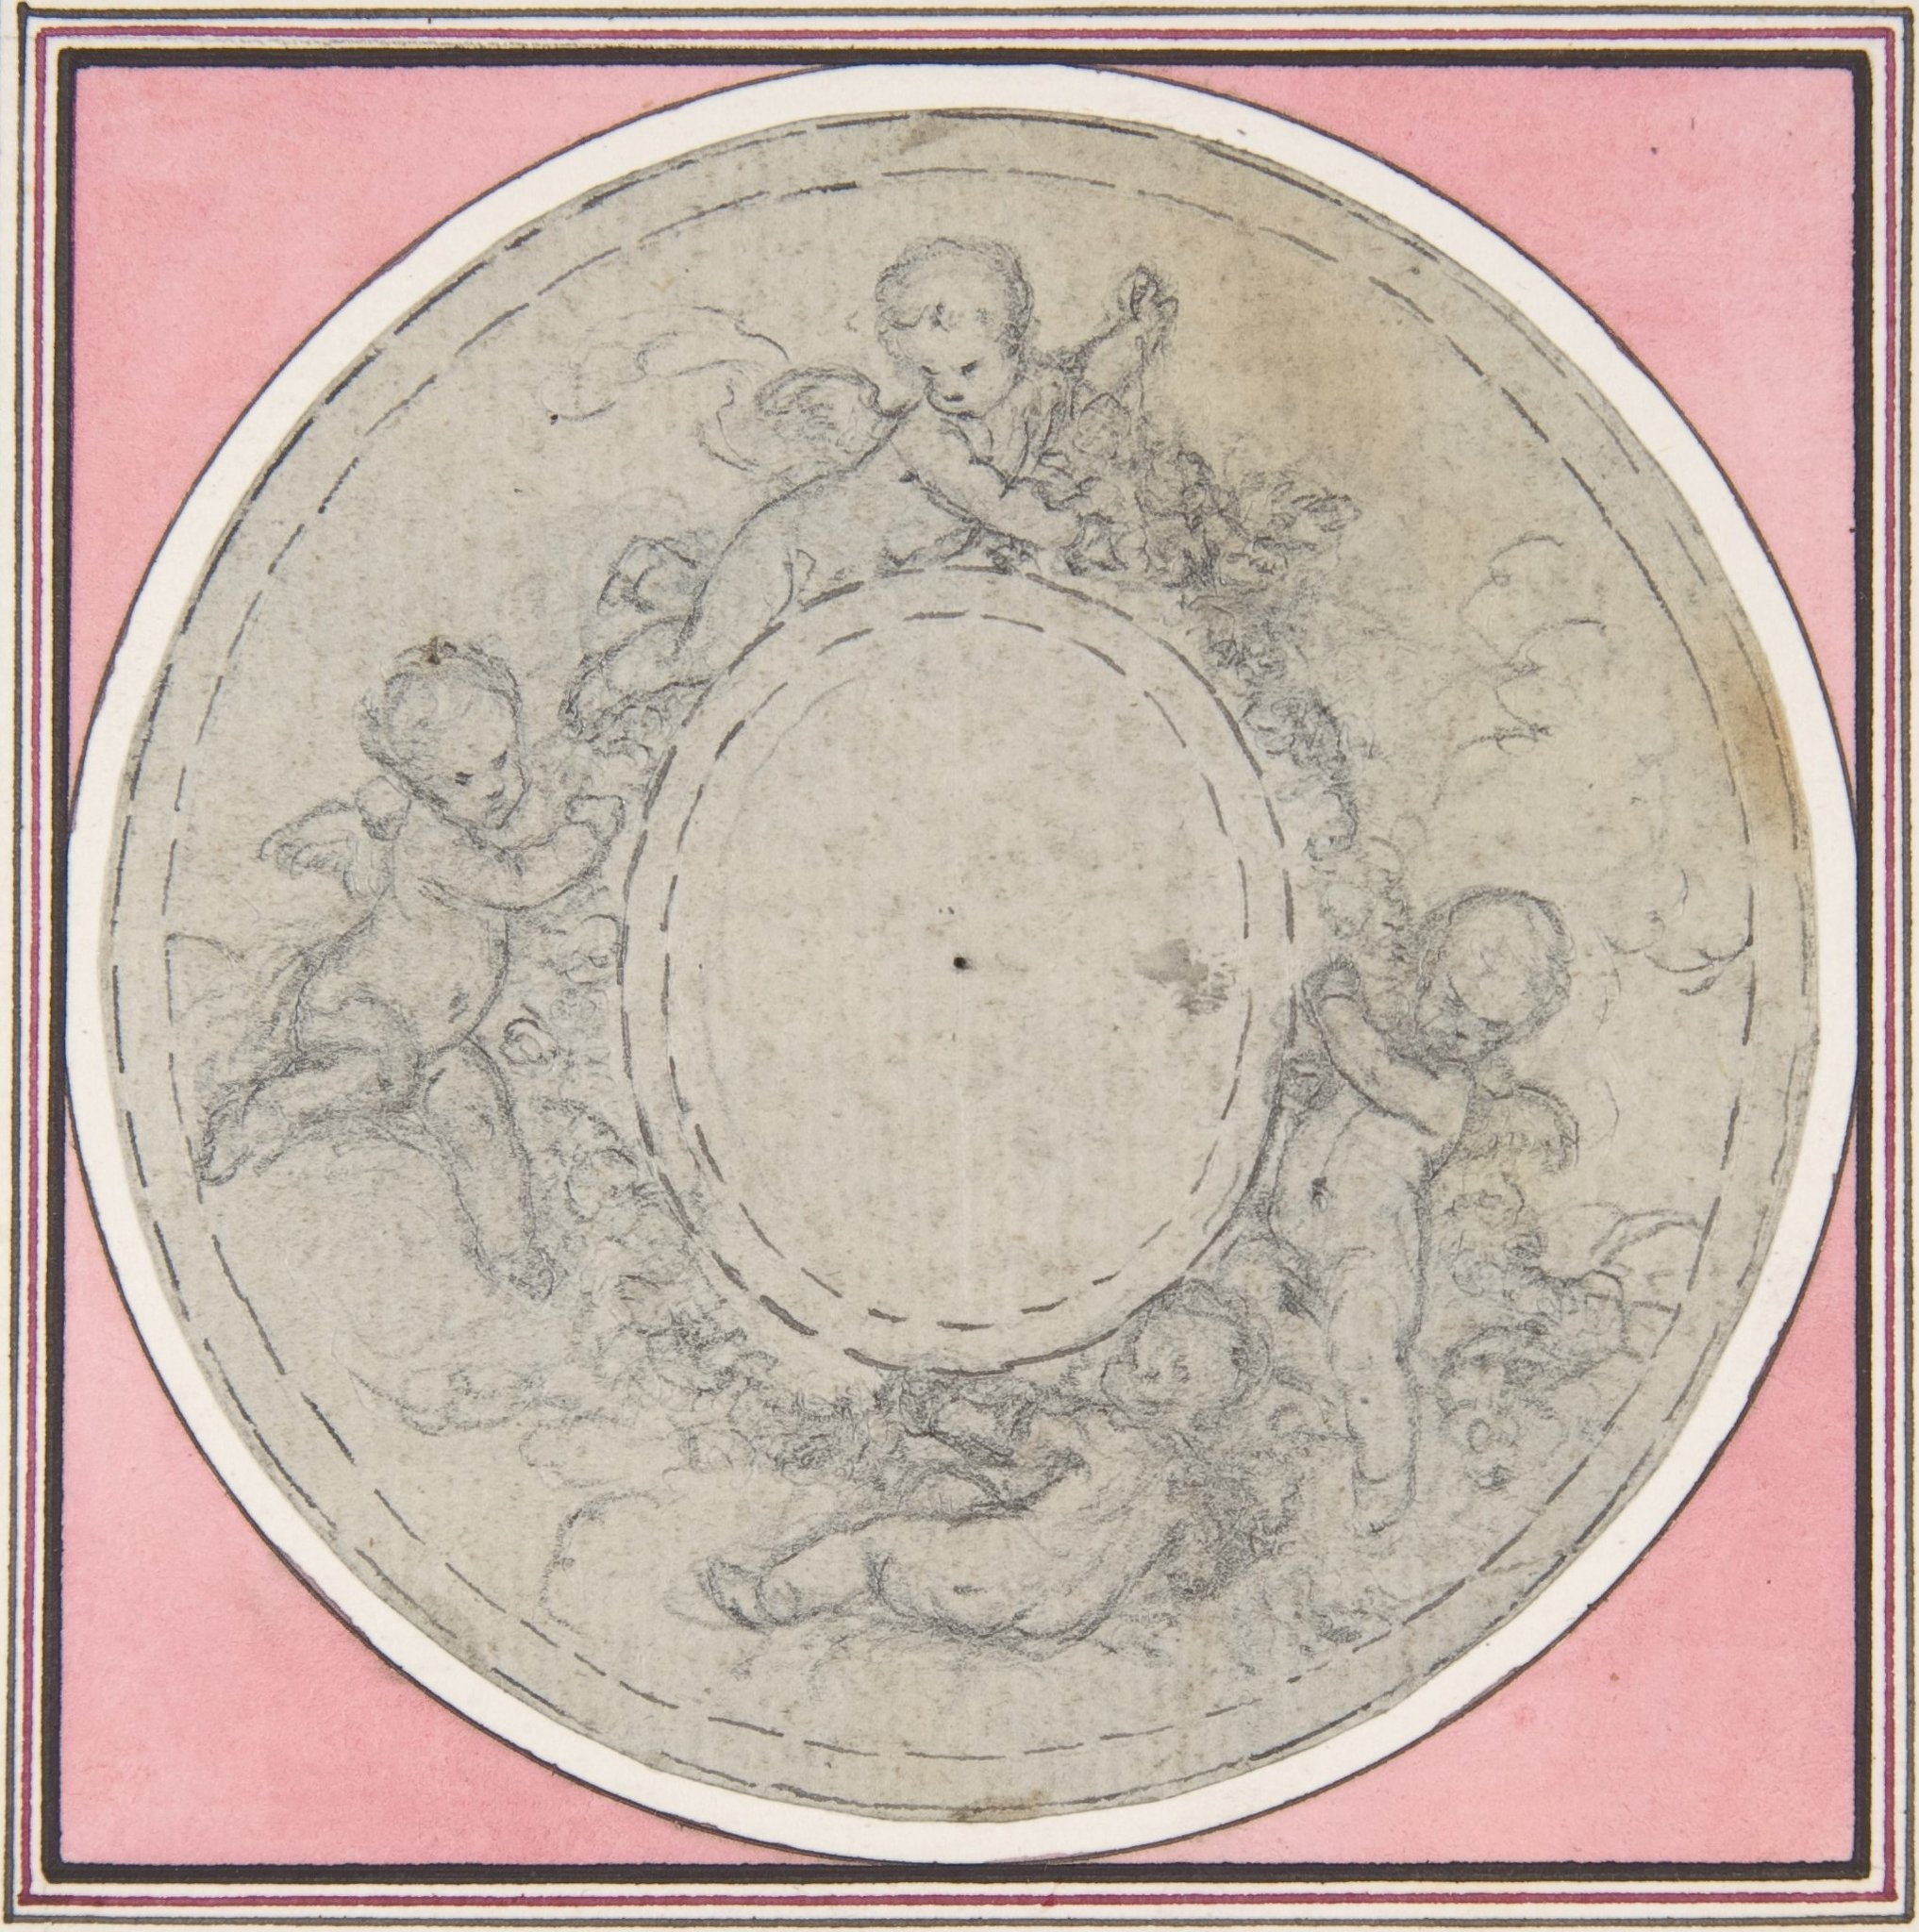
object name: drawing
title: Design for a Box-Lid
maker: hubert françois gravelot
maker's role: artist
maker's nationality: french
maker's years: 1699-1773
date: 1701-1800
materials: chalk, graphite